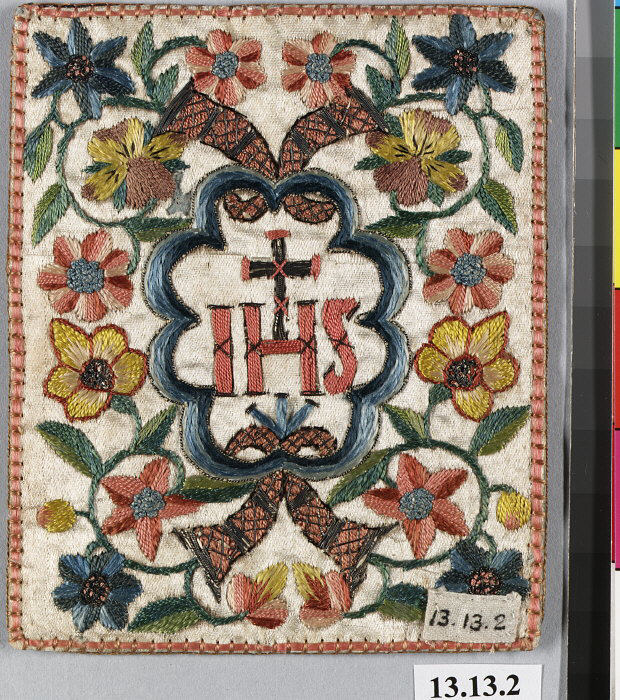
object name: panel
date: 1701-1800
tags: flowers